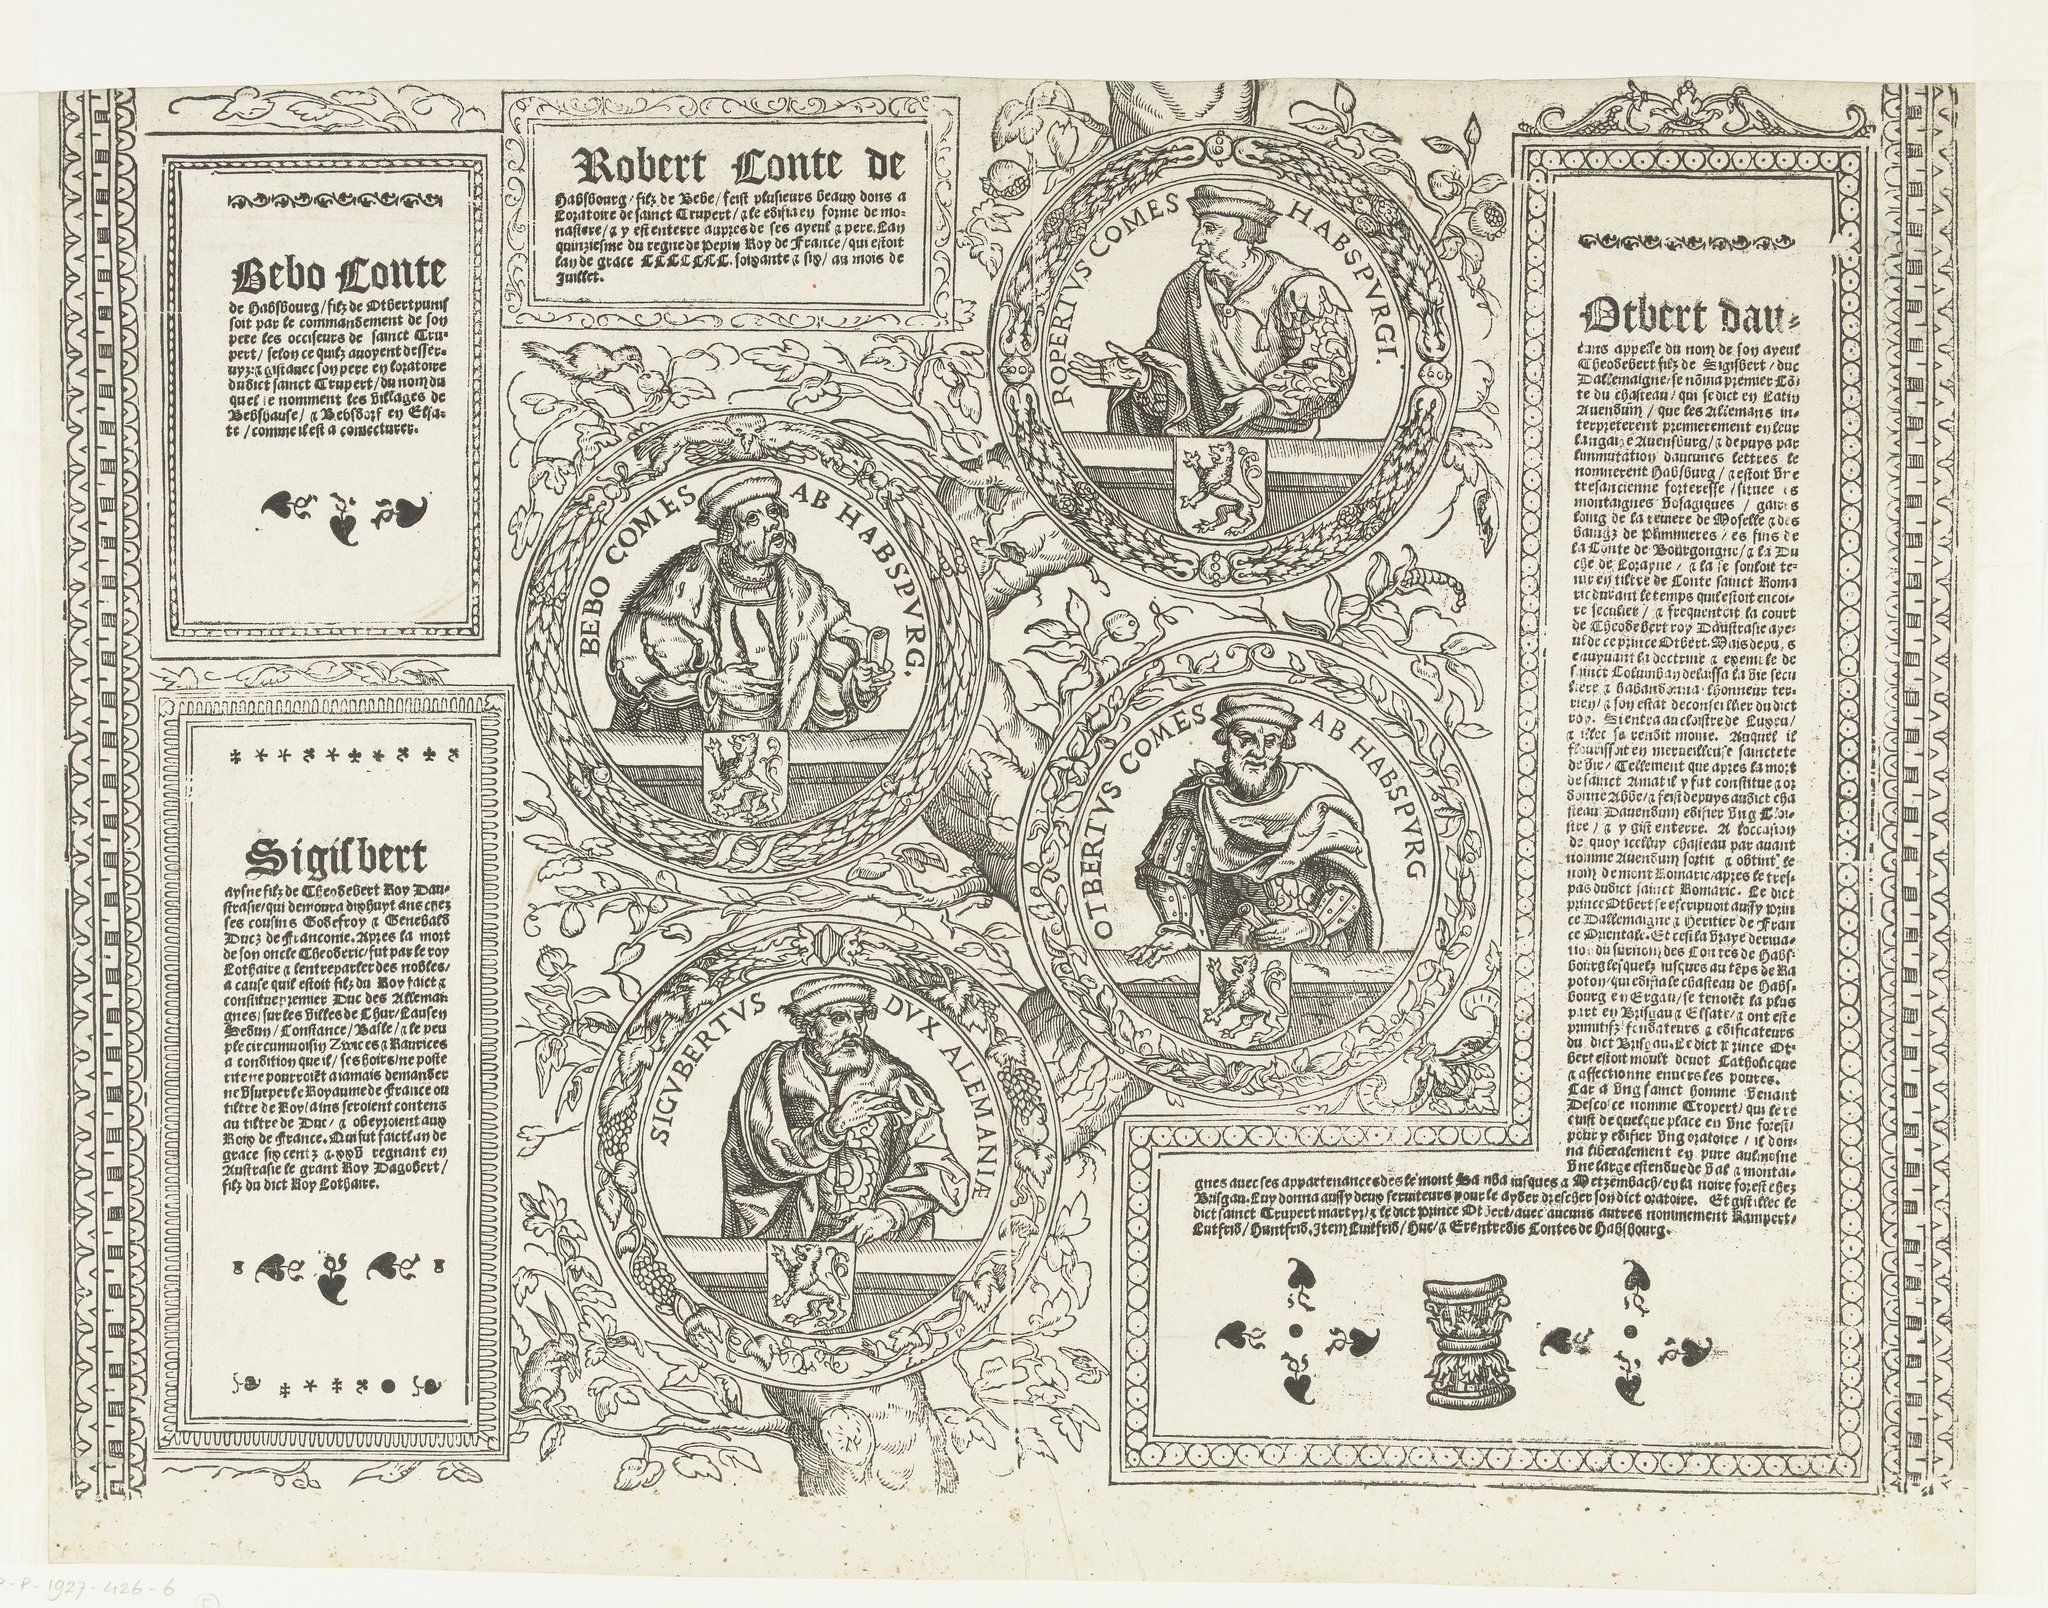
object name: print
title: Stamboom van het Habsburgse Huis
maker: robert péril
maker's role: draughtsman, print maker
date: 1533-1535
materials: paper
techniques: woodcut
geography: low countries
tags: family lineage, pedigree, genealogical tree or table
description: Eén blad van twintig, vormen samen een stamboom. In de boom vier medaillons met Sigibert II en de drie graven van Habsburg: Othbert, Bebo en Robert. Vier cartouches met tekst in het Frans.